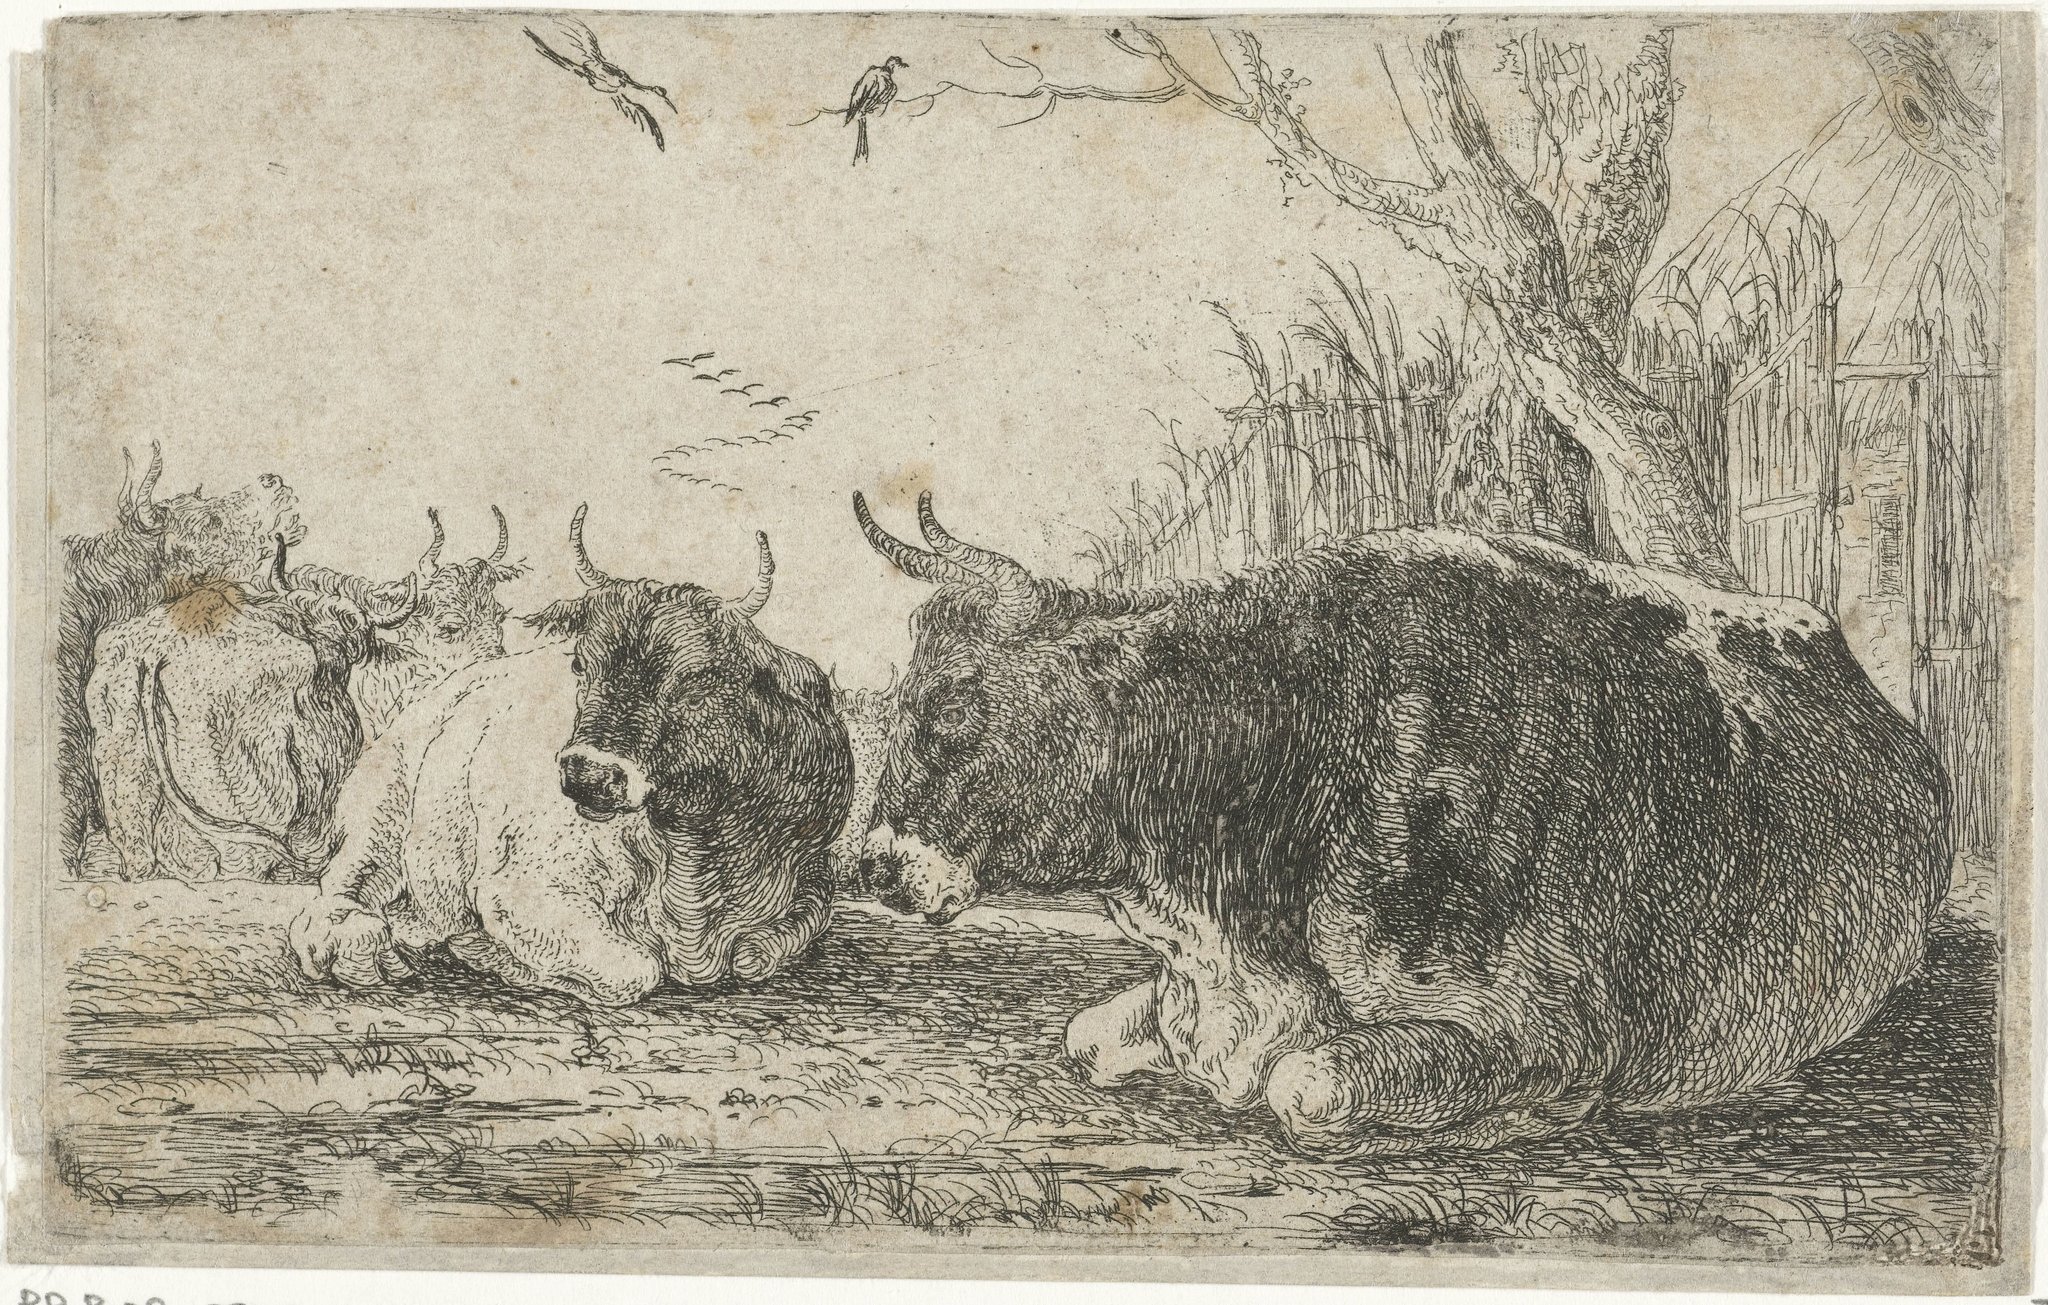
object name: print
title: Zoographiam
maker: jan van den hecke (i)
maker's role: print maker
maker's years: 1619-1684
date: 1656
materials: paper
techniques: etching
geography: brussels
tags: cow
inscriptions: collector's mark: Lugt 2228